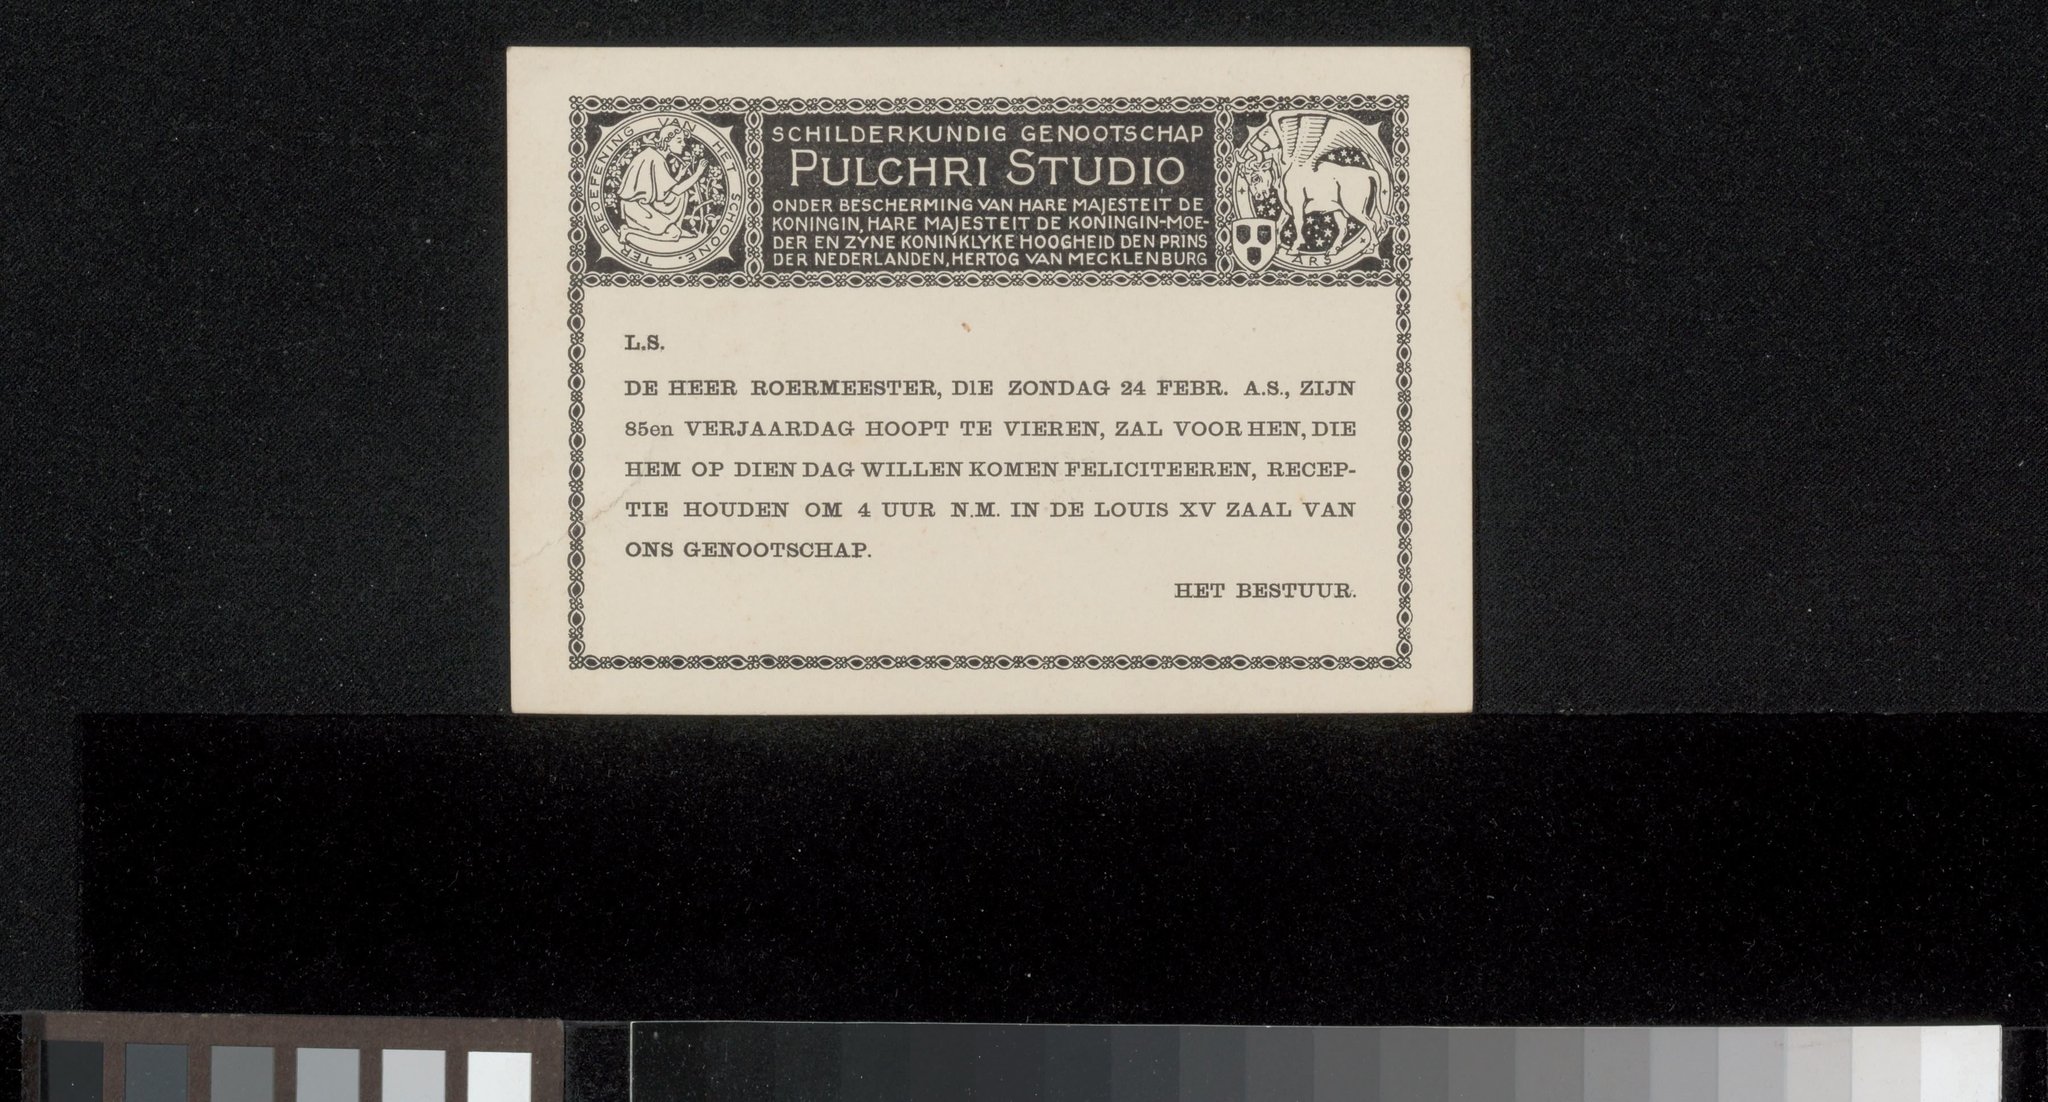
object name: invitation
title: Uitnodiging aan Philip Zilcken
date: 1929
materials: cardboard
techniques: printing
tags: print maker, gerardus johannes roermeester, the hague, painter, draughtsman, philip zilcken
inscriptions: collector's mark: ‘RPK’